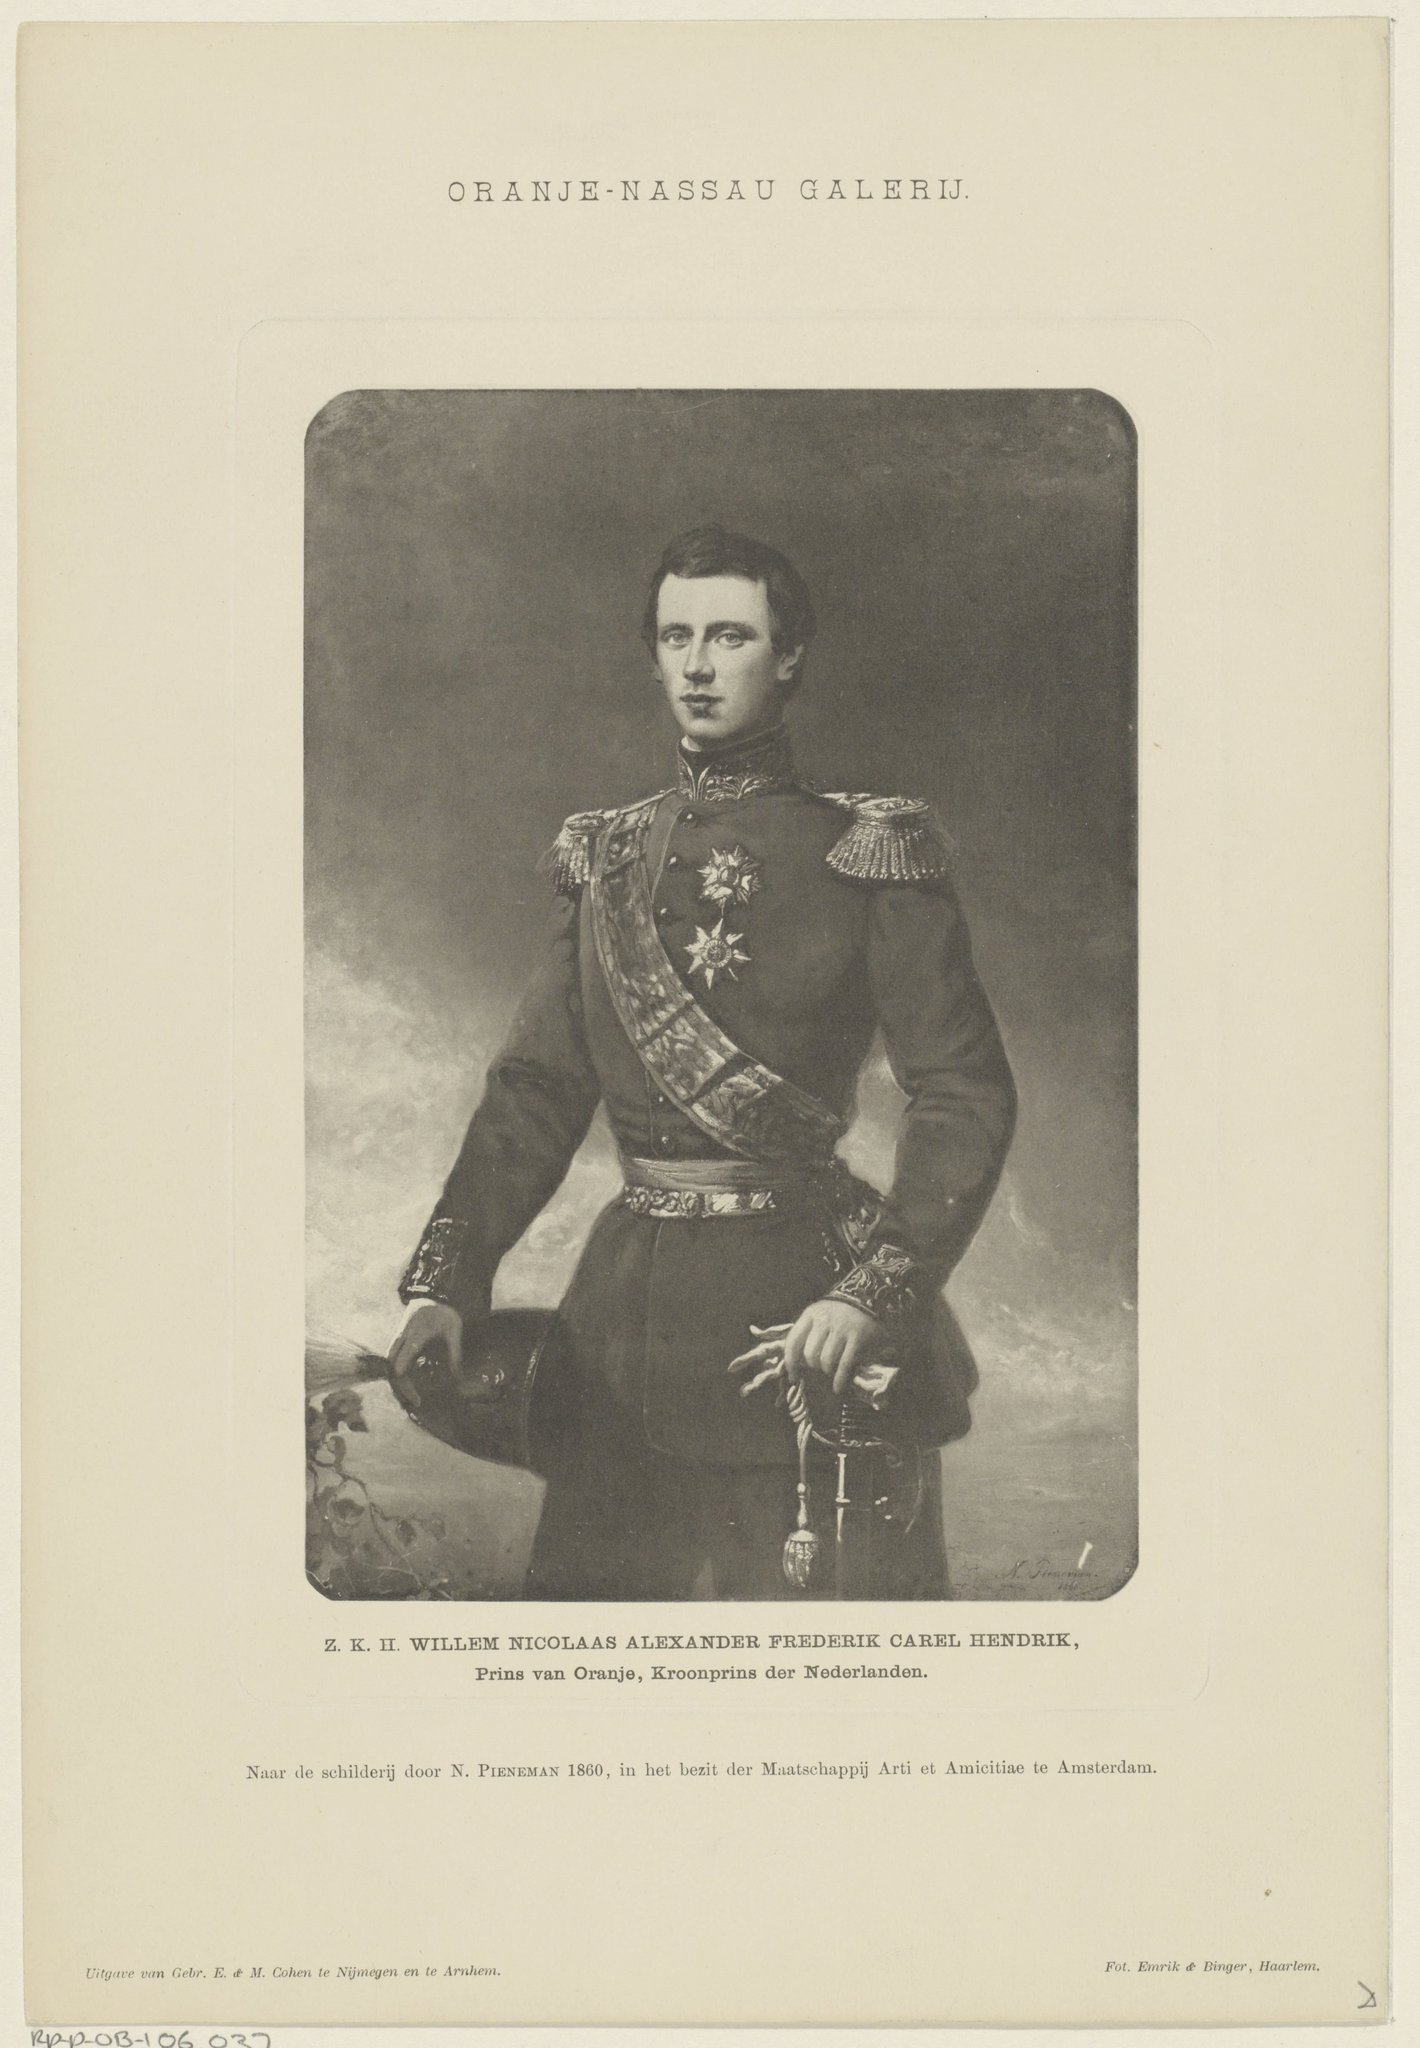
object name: photomechanical print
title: Portret van Willem, prins der Nederlanden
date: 1860-1903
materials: paper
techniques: photograph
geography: arnhem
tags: the hague, paris, willem (prins der nederlanden)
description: De hier vermelde titel verwijst naar de hoogst verkregen titel van de geportretteerde, niet per se naar de titel die de geportretteerde op deze voorstelling draagt.